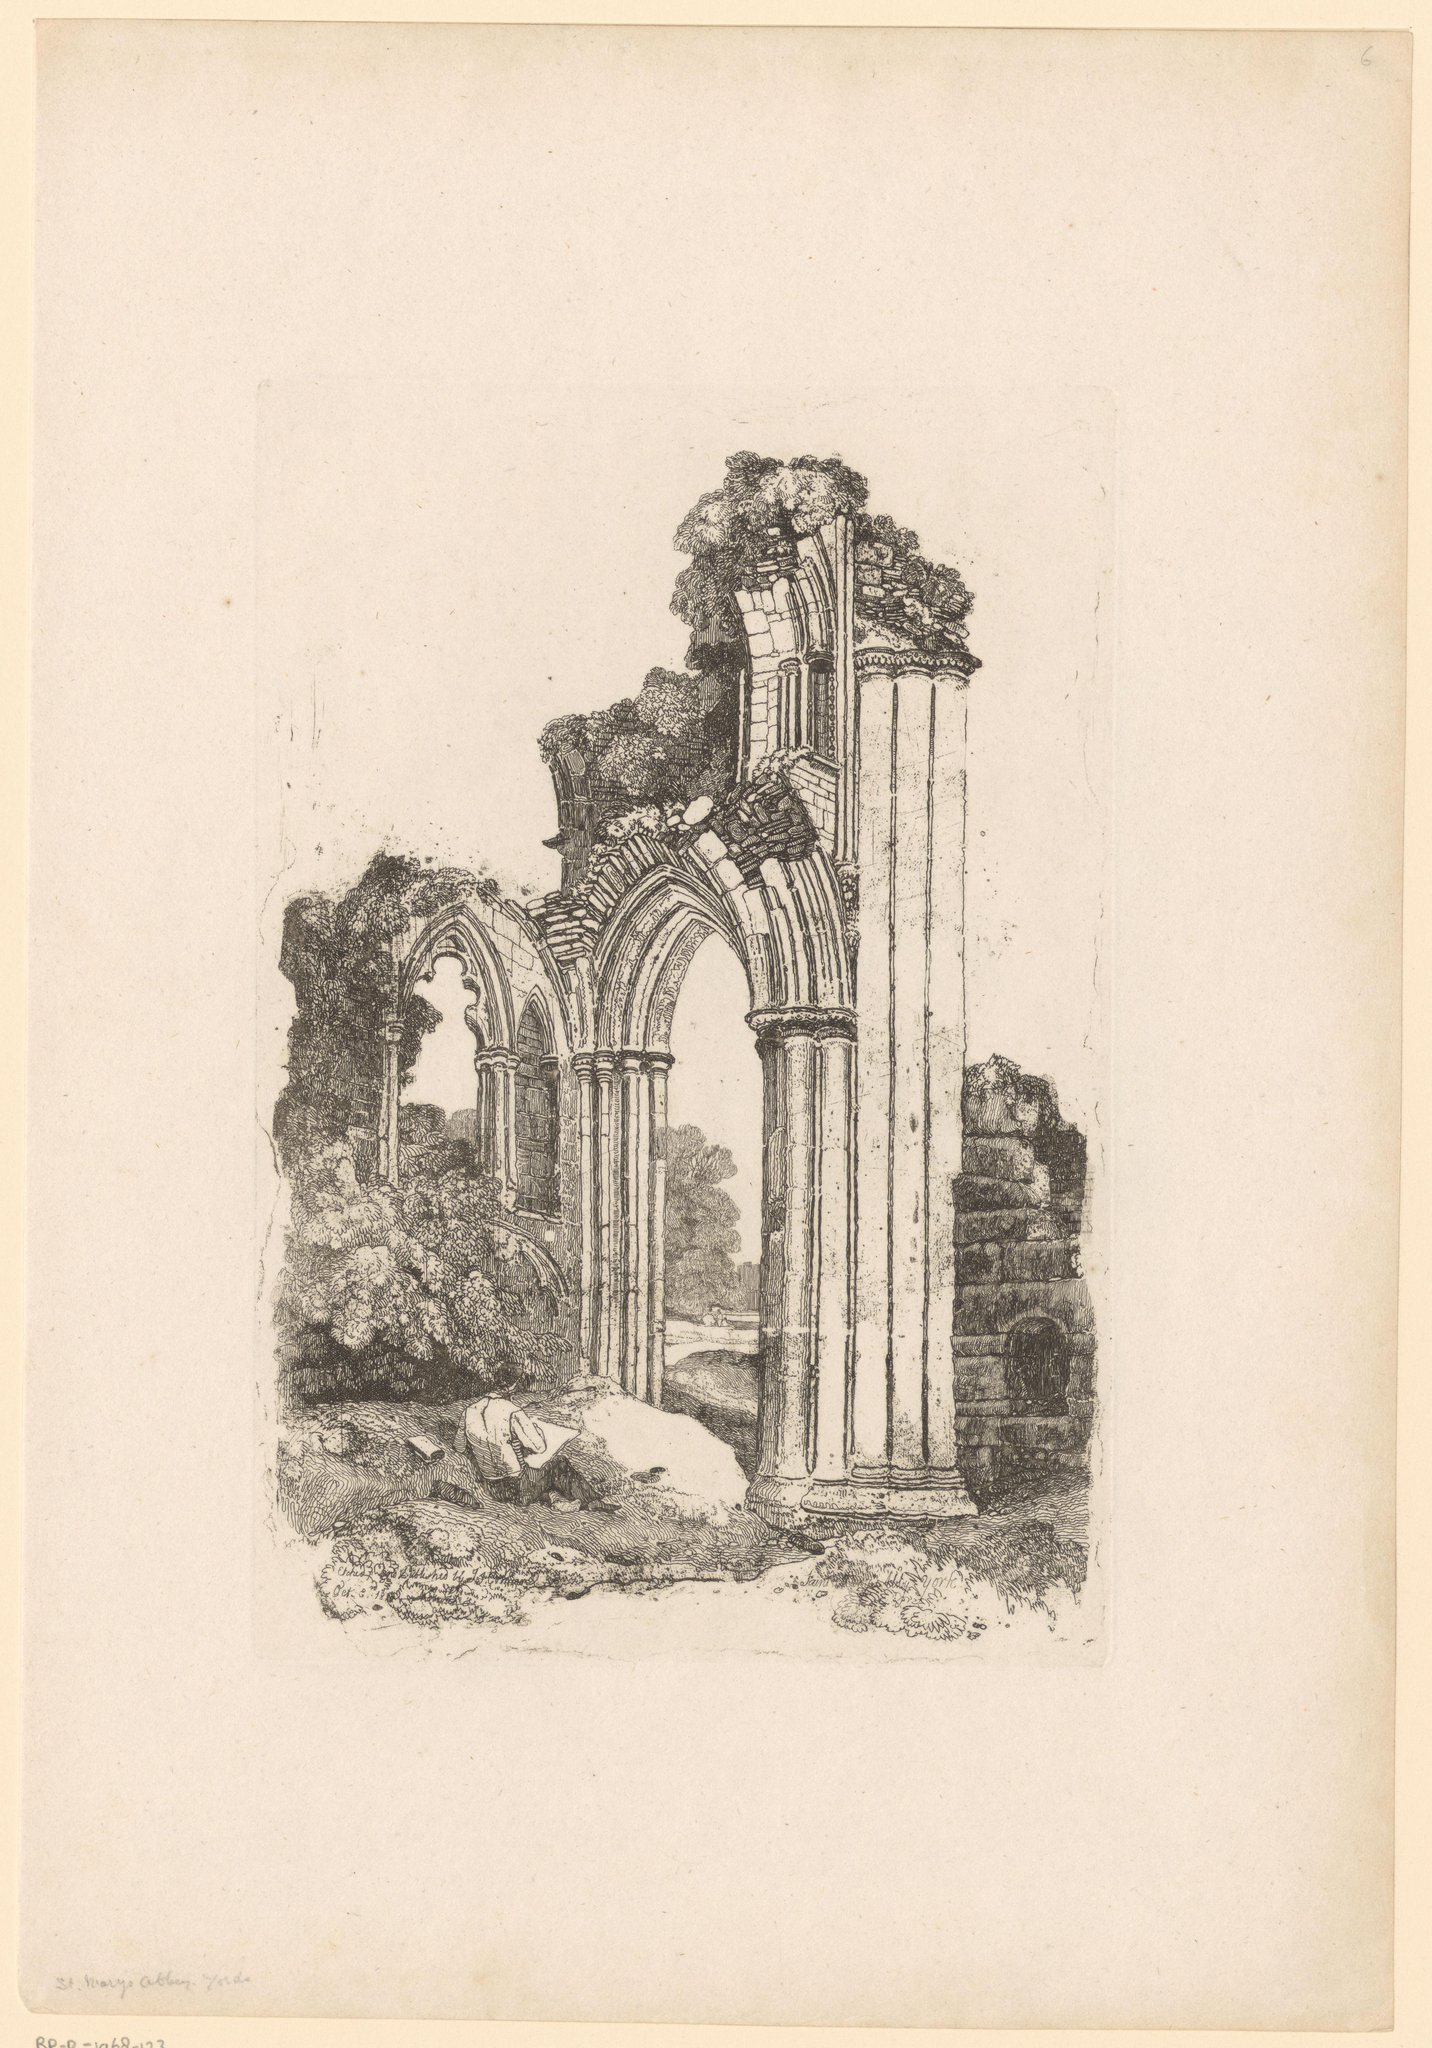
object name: print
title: Saint Mary's Abby York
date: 1810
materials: paper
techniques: etching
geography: edinburgh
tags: ruin of church, monastery, etc.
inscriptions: collector's mark: Lugt 2228, collector's mark: Lugt 2760